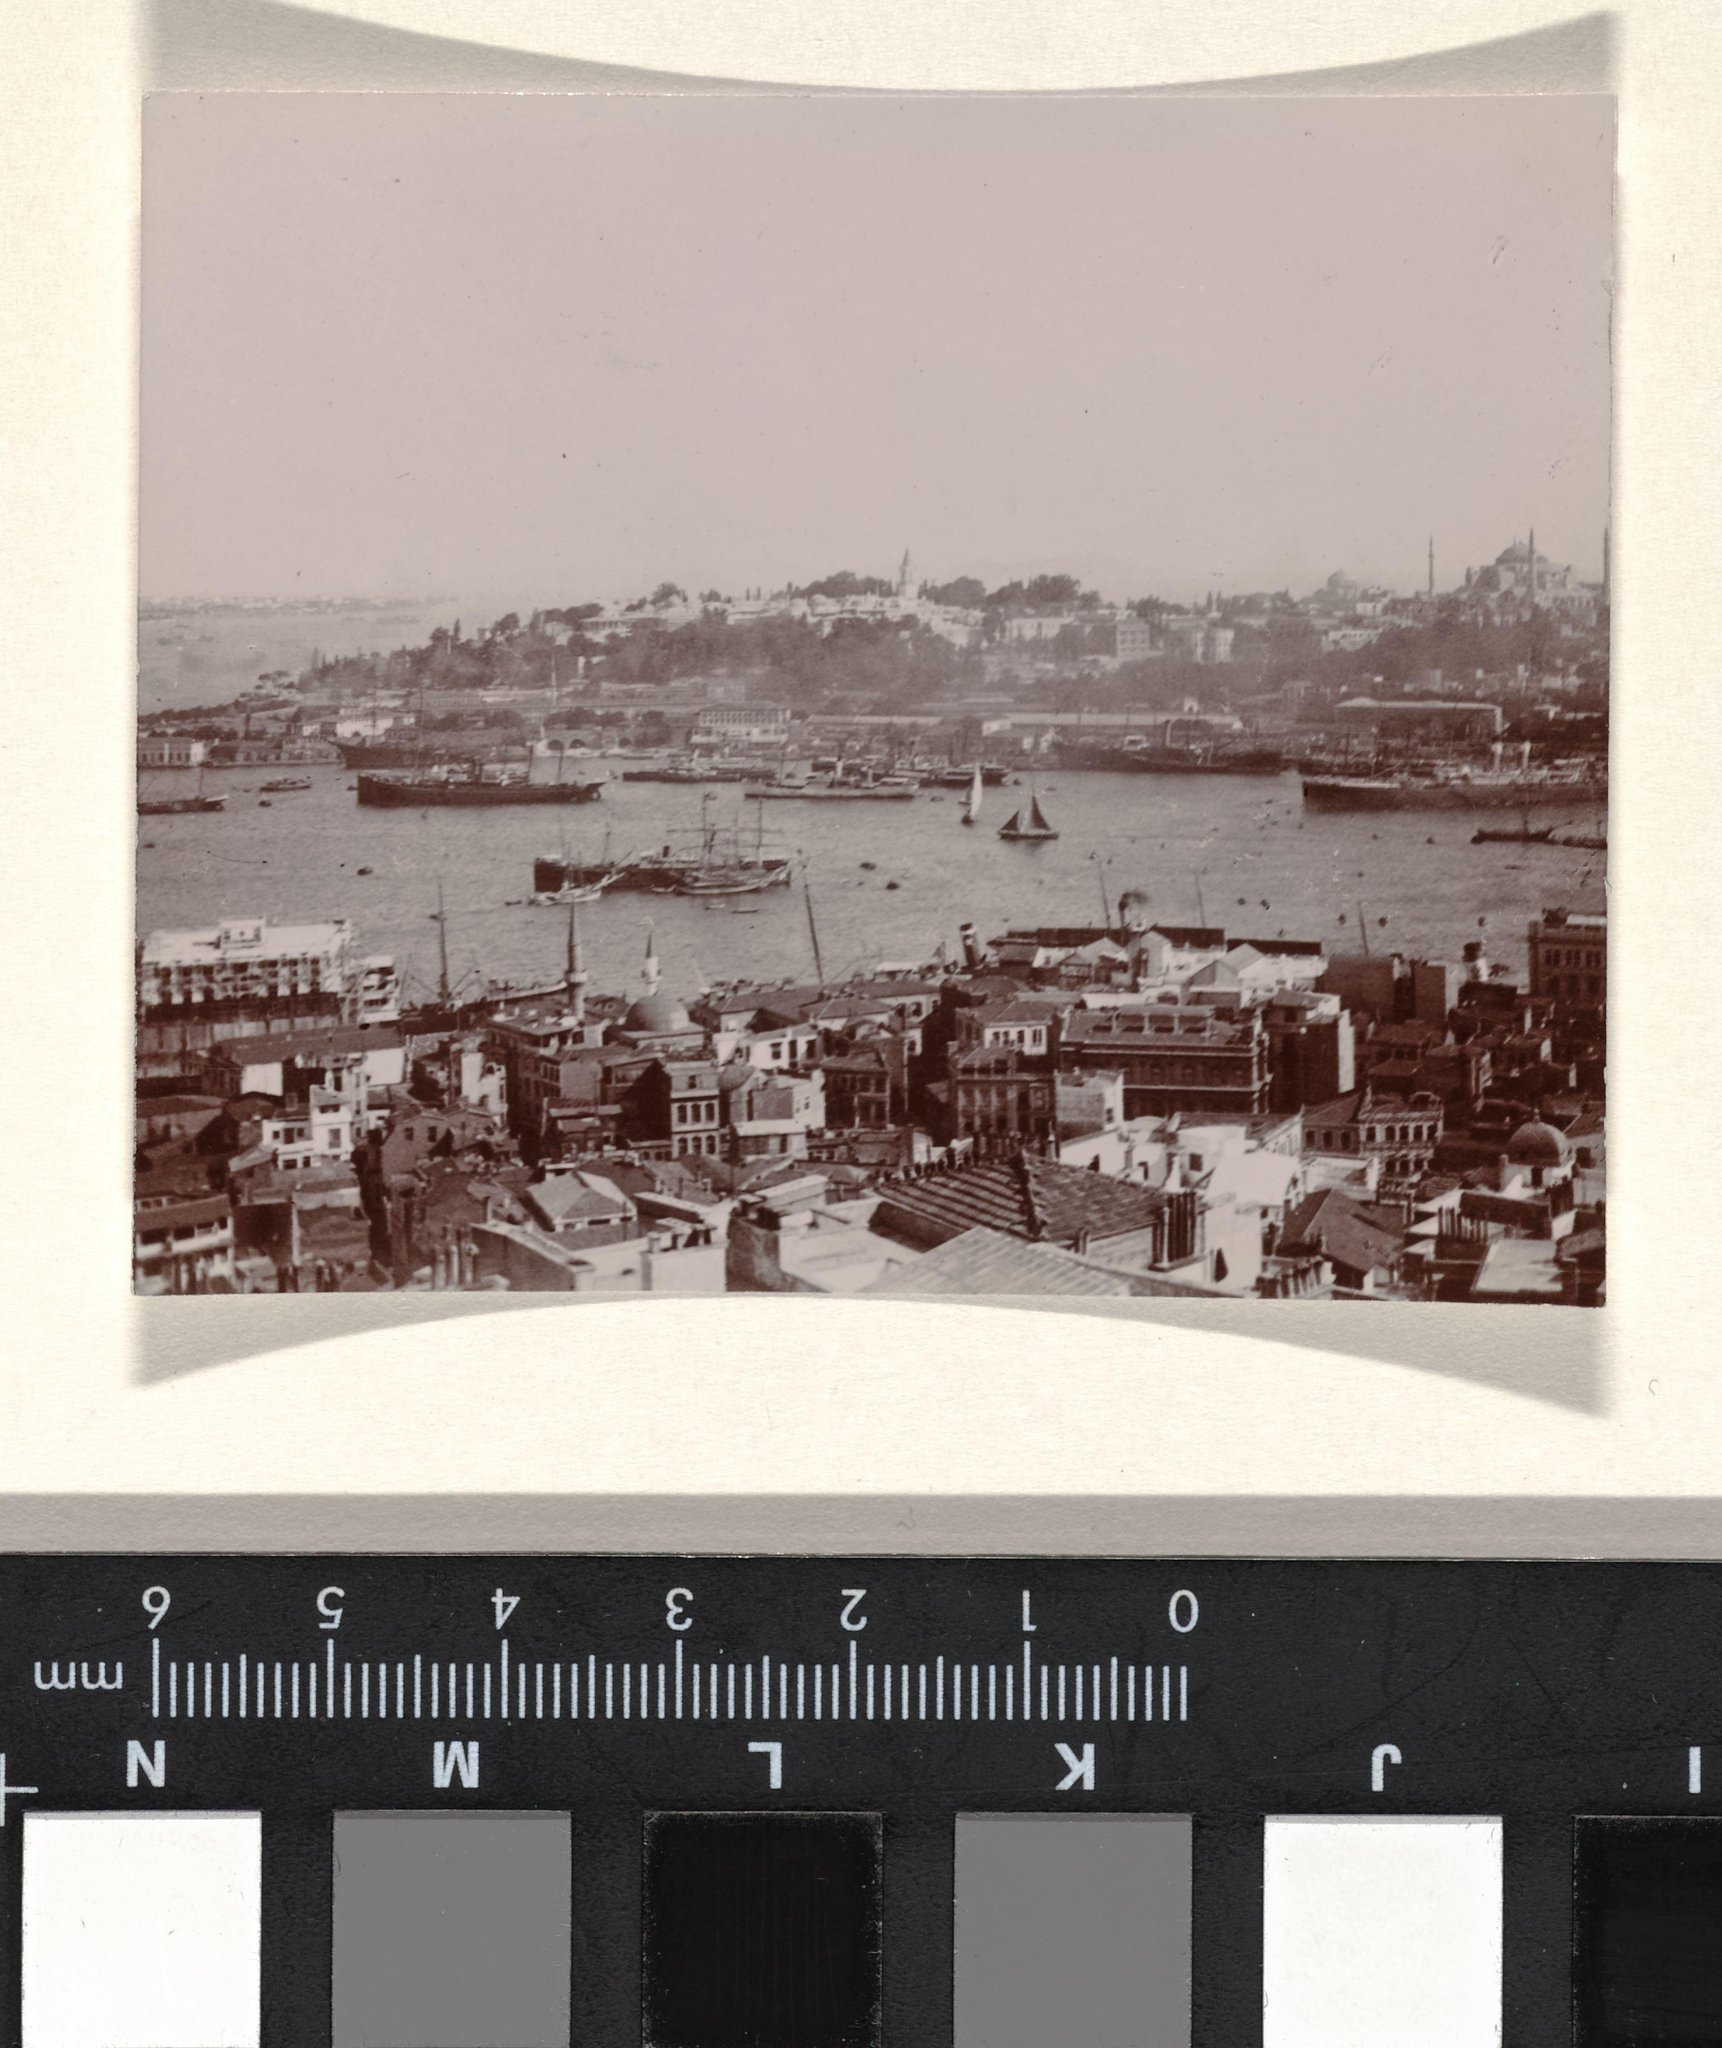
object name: photograph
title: Istanbul met twee oevers van de rivier de Bosporus en schepen op de rivier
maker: Anonymous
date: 1909-1918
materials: photographic support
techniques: gelatin silver print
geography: istanbul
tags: eugen wachenheimer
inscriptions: inscription: ‘2) Vonn Galata Hafen gegenüber in Istanbul ganz rechts die Aja Sofia. Nach den Meer zu ... die sogen. kraispitze die die zahlreichen Gebäude trägt die früher den ... den Sultane bildeten. Heute ist da die Schatkamer Museum ... ... ... Istanbul sicht man die ... der ... das Marmarameer’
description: Istanbul met twee oevers van de rivier de Bosporus en schepen op de rivier.